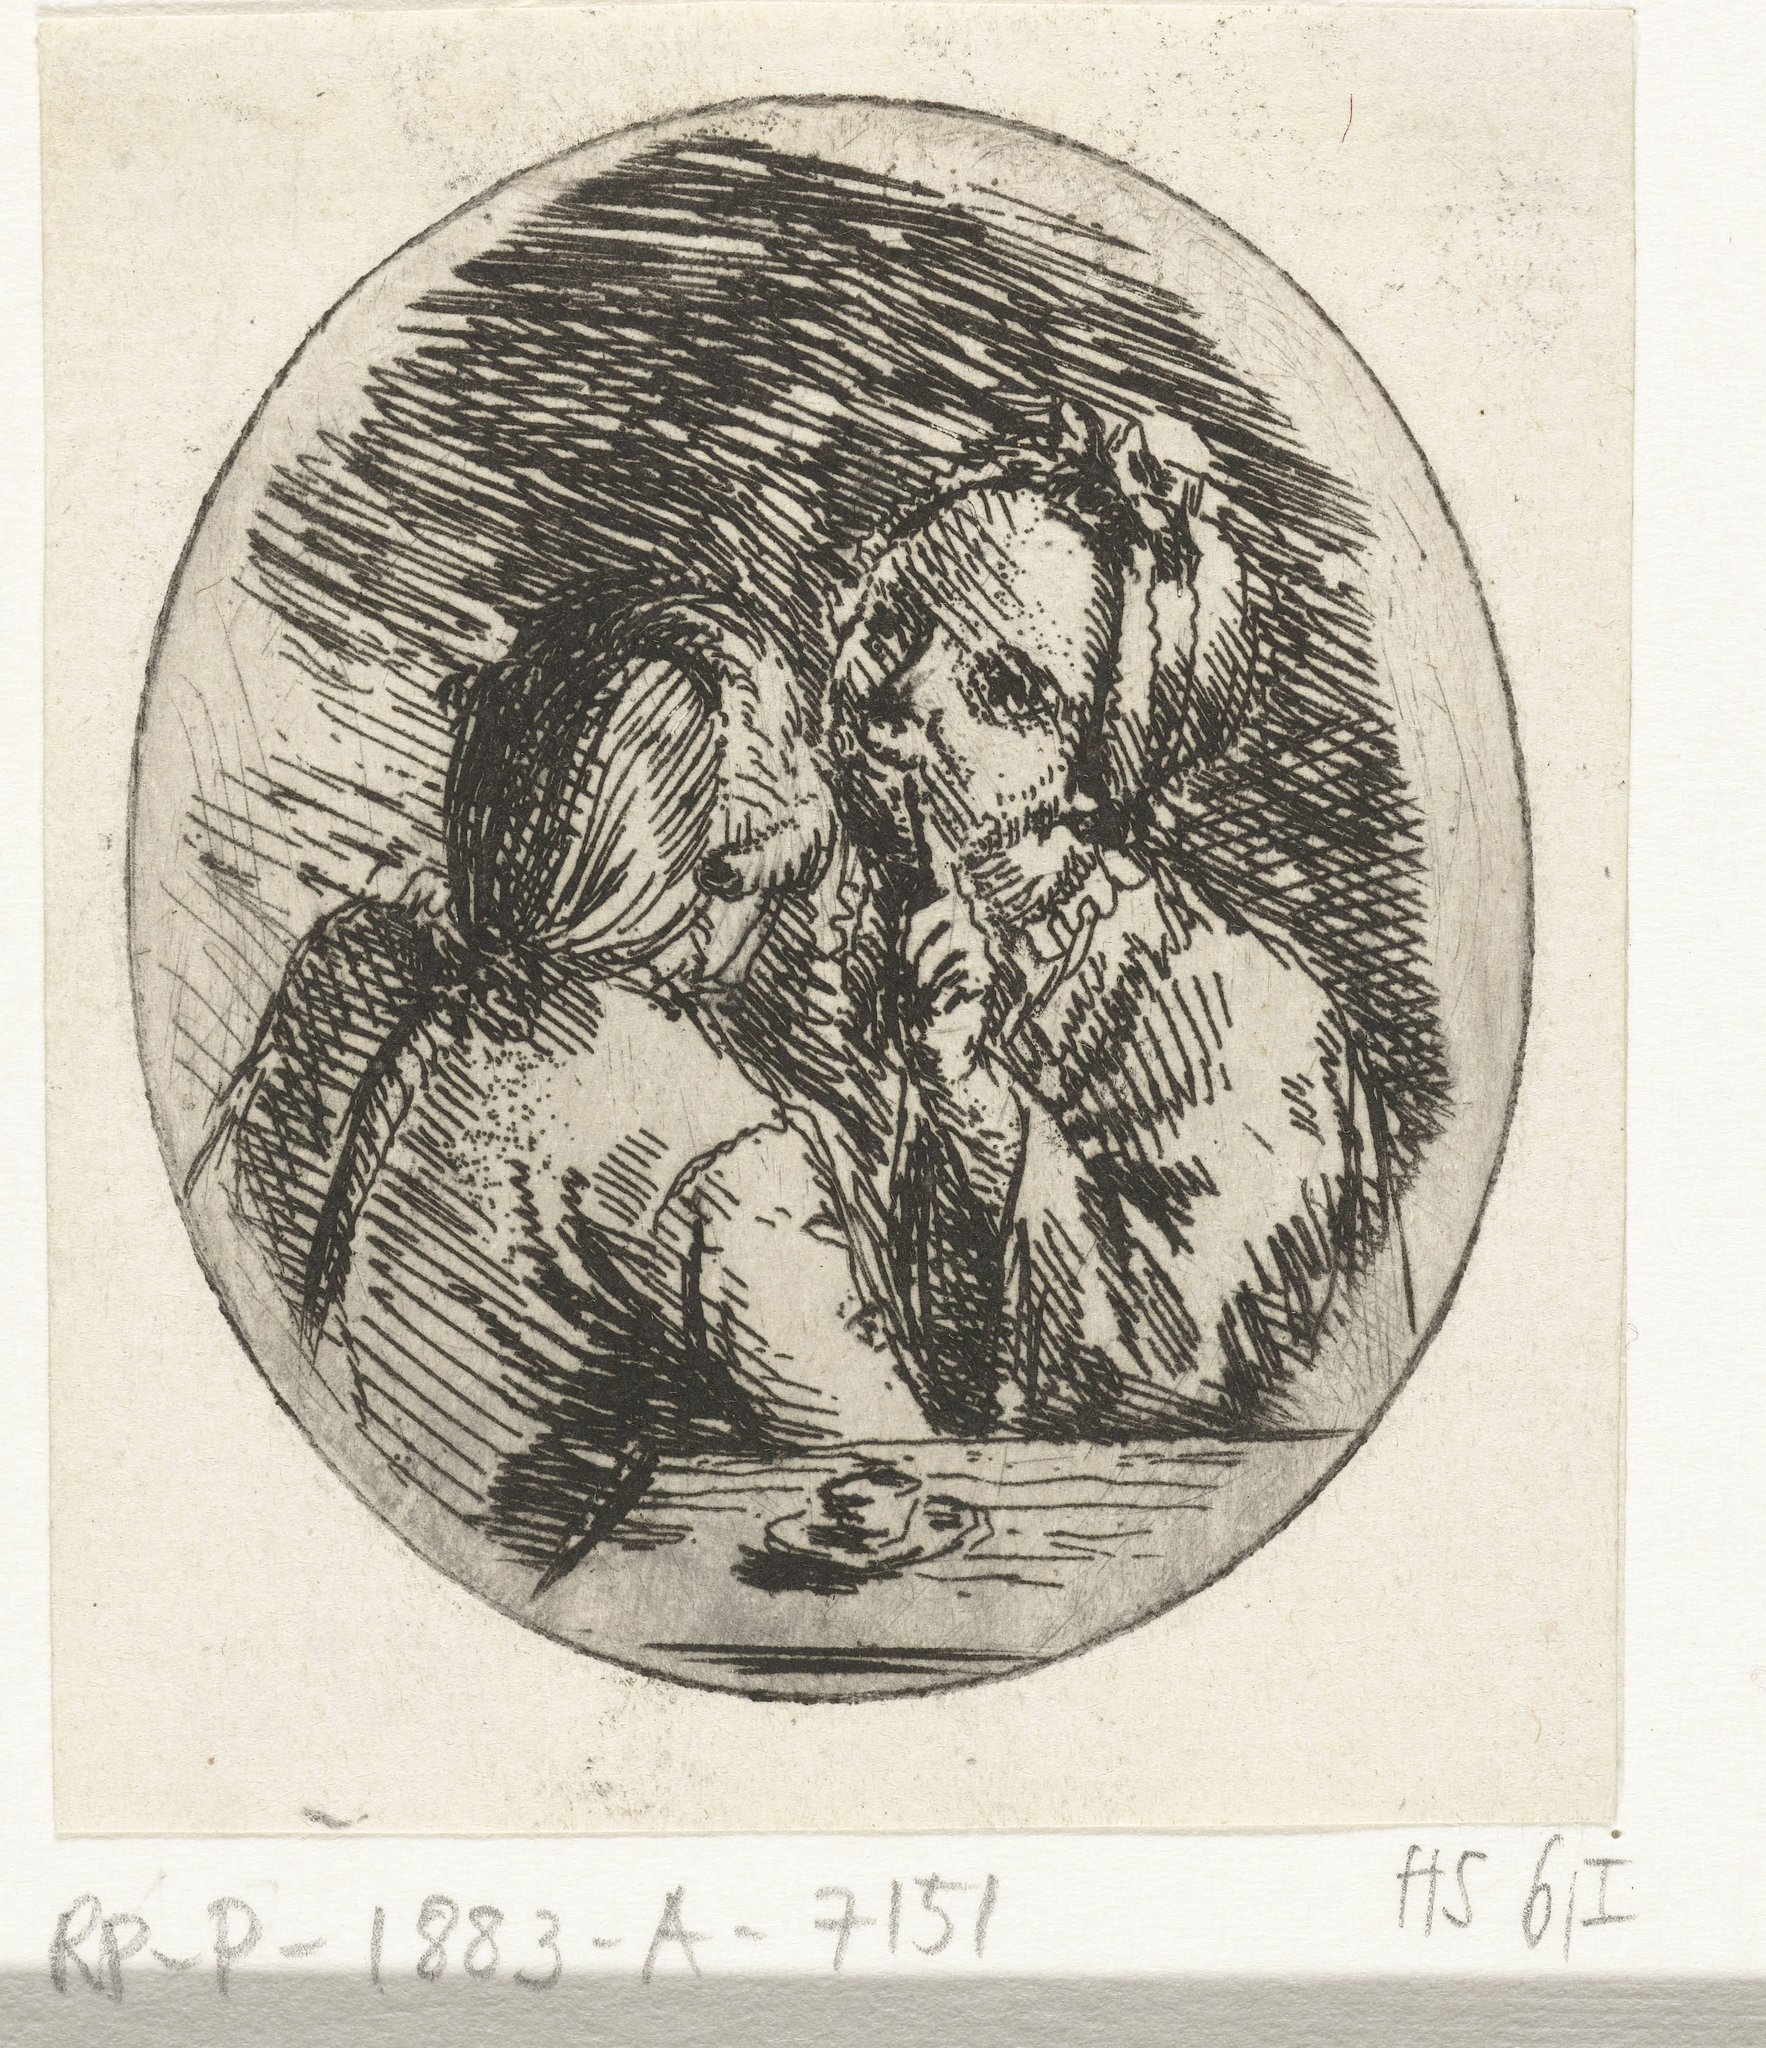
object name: print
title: Man en vrouw in gesprek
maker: louis bernard coclers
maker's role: draughtsman, print maker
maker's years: 1741-1817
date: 1756-1817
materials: paper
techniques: drypoint, etching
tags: conversation, dialogue; conversation piece, index finger forwards, pointing, indicating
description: Een man en een vrouw zitten aan de koffietafel. De vrouw houdt vermanend haar vinger omhoog.